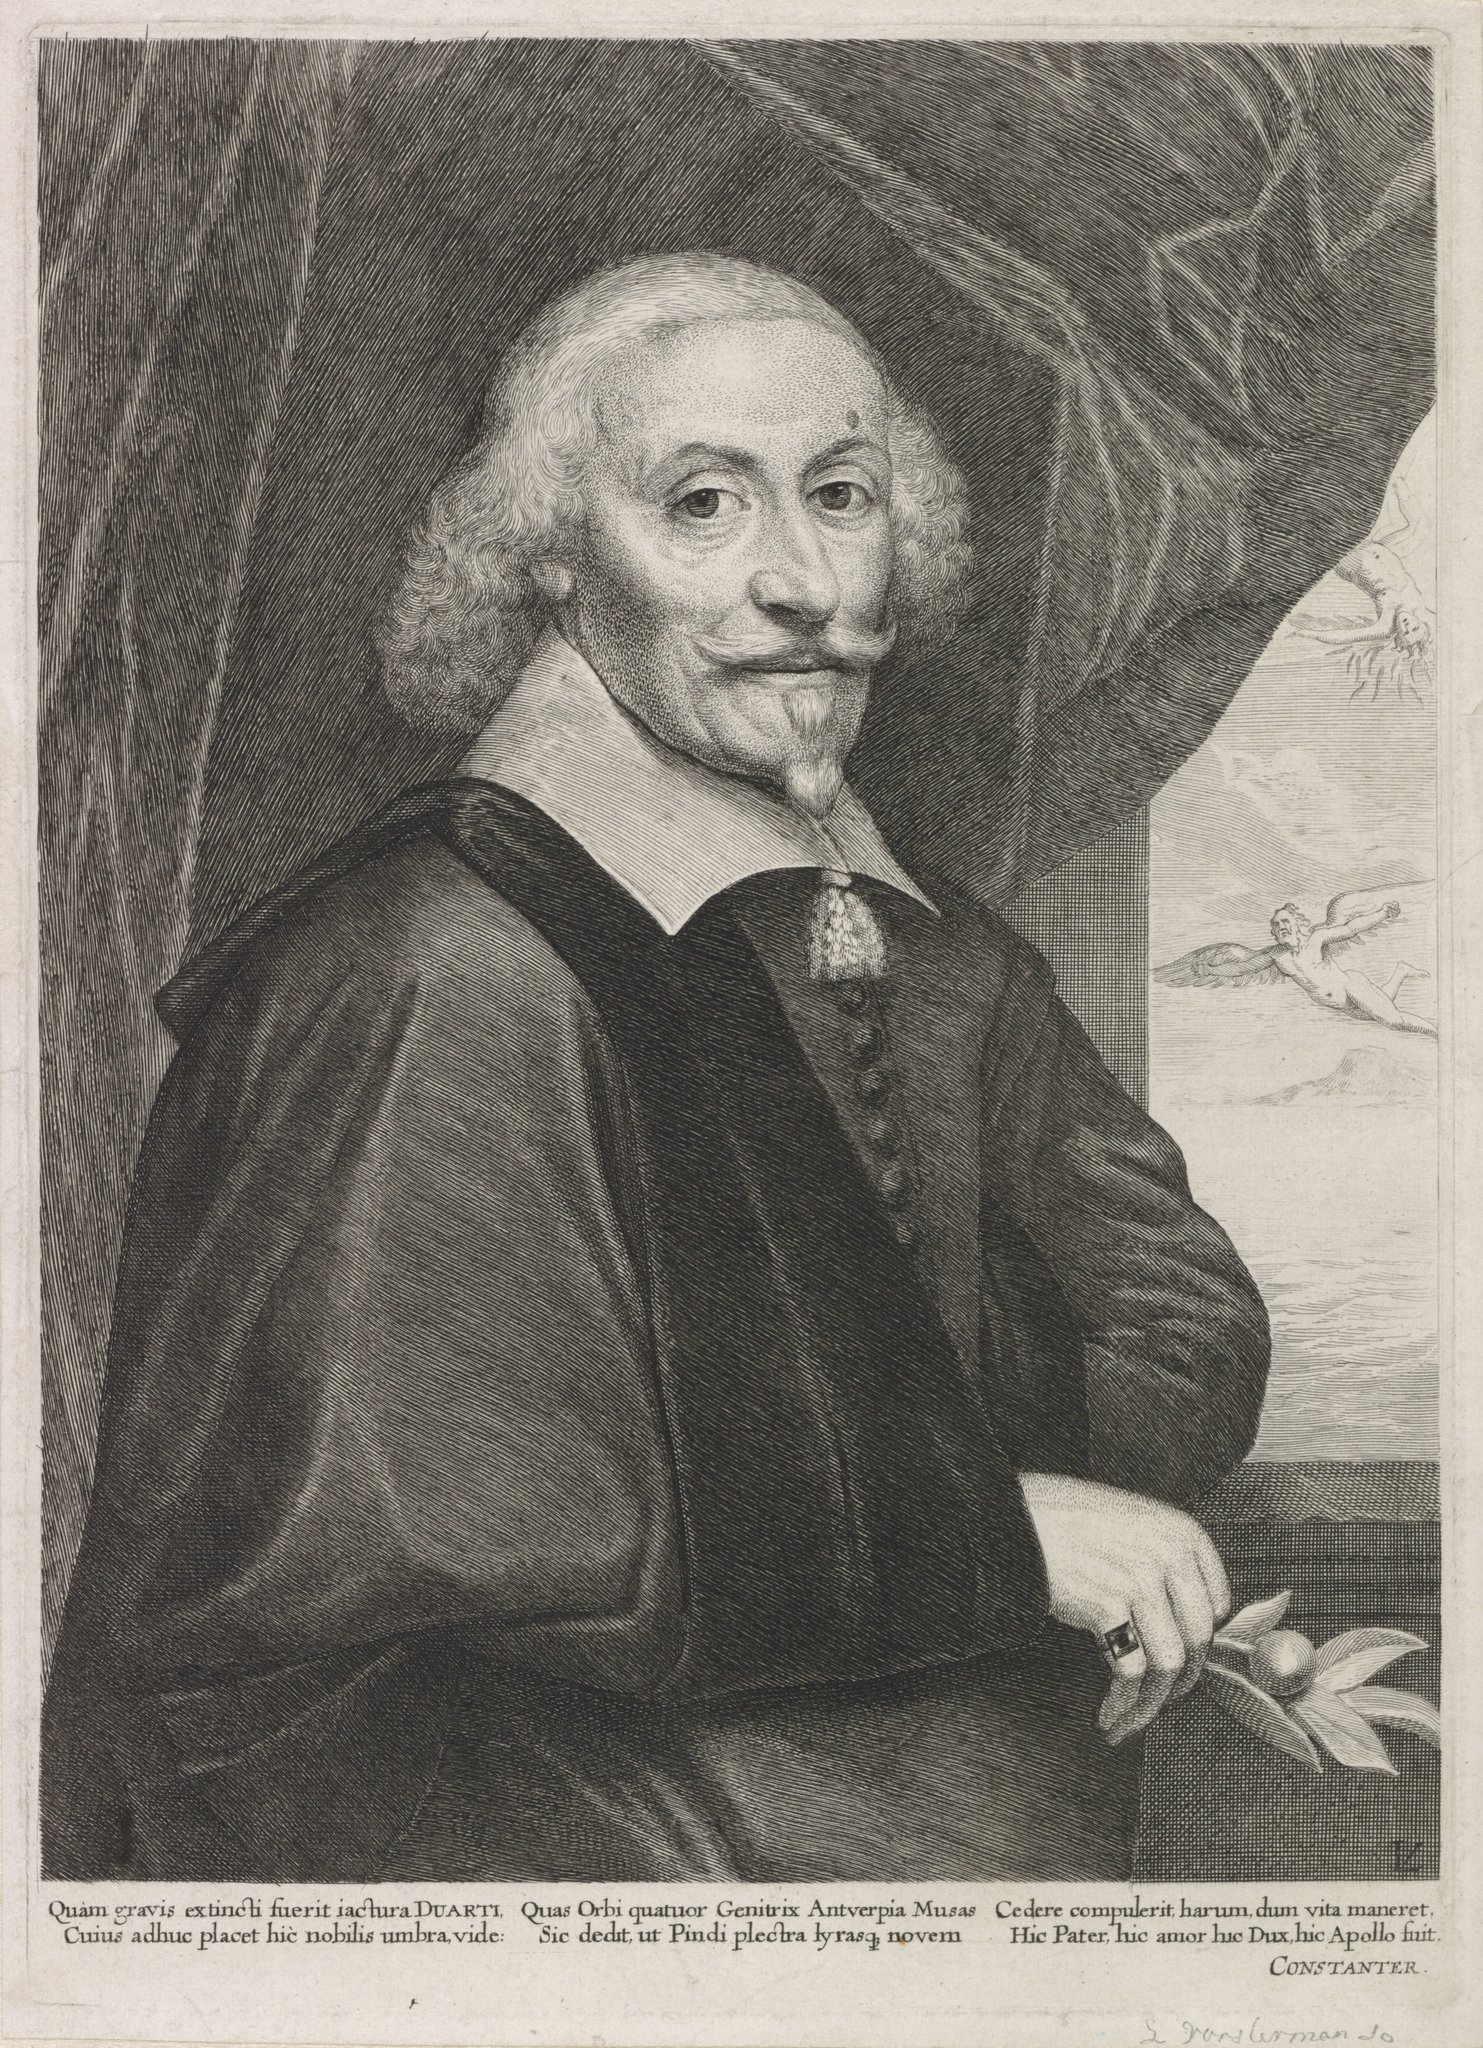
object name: print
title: Portret van Gaspard Duarte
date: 1657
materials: paper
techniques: engraving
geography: antwerp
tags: death i.e. the fall of icarus (daedalus present)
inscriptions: collector's mark: Lugt 2228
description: Portret van de Antwerpse bankier, juwelier en muziekliefhebber Gaspard Duarte. Op de achtergrond, door het raam, de val van Icarus.